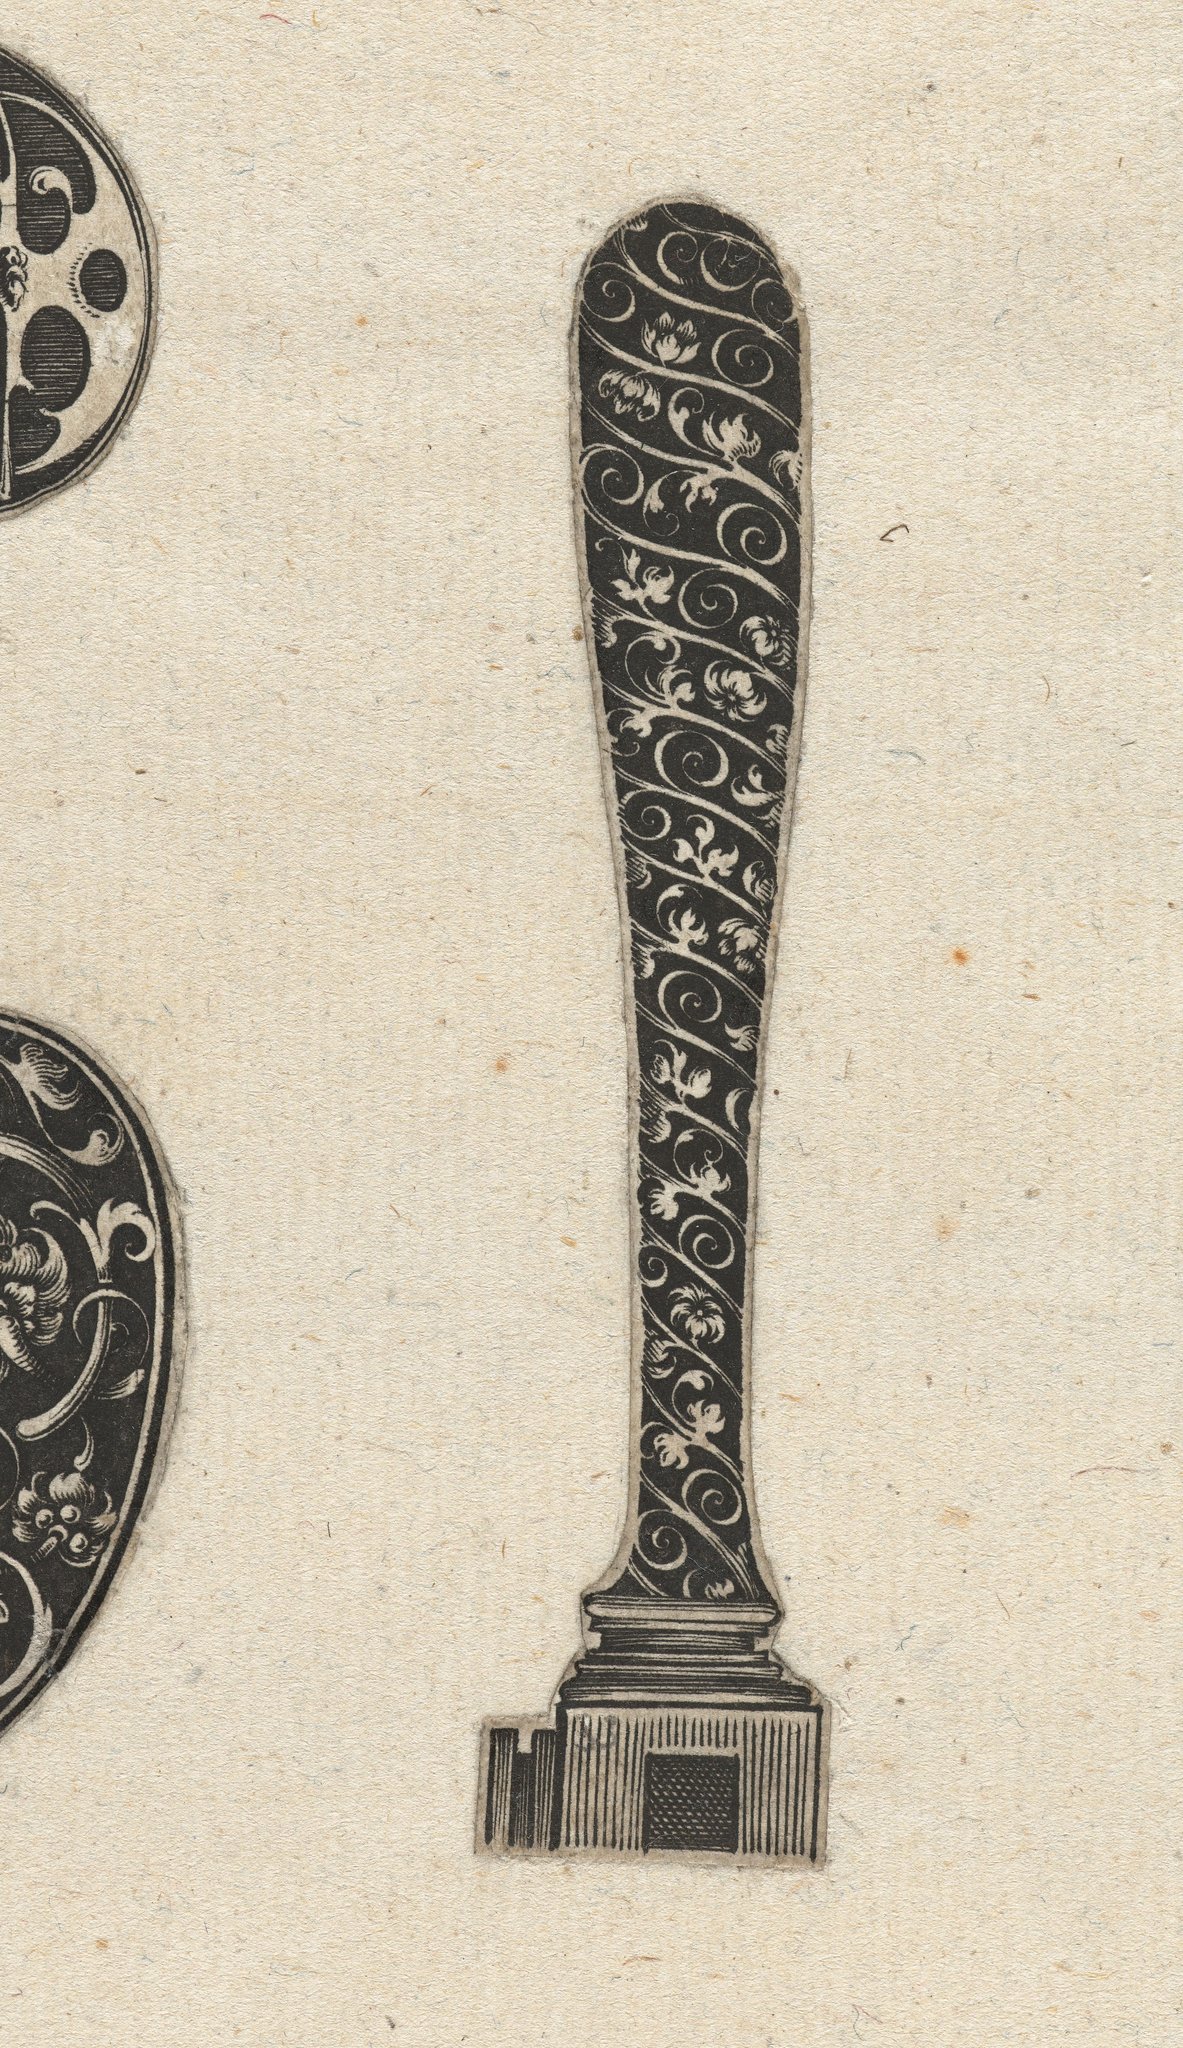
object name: ornament print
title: Quillon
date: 1597-1656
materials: paper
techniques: etching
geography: amsterdam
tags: hacking and thrusting weapons: dagger (+ variant)